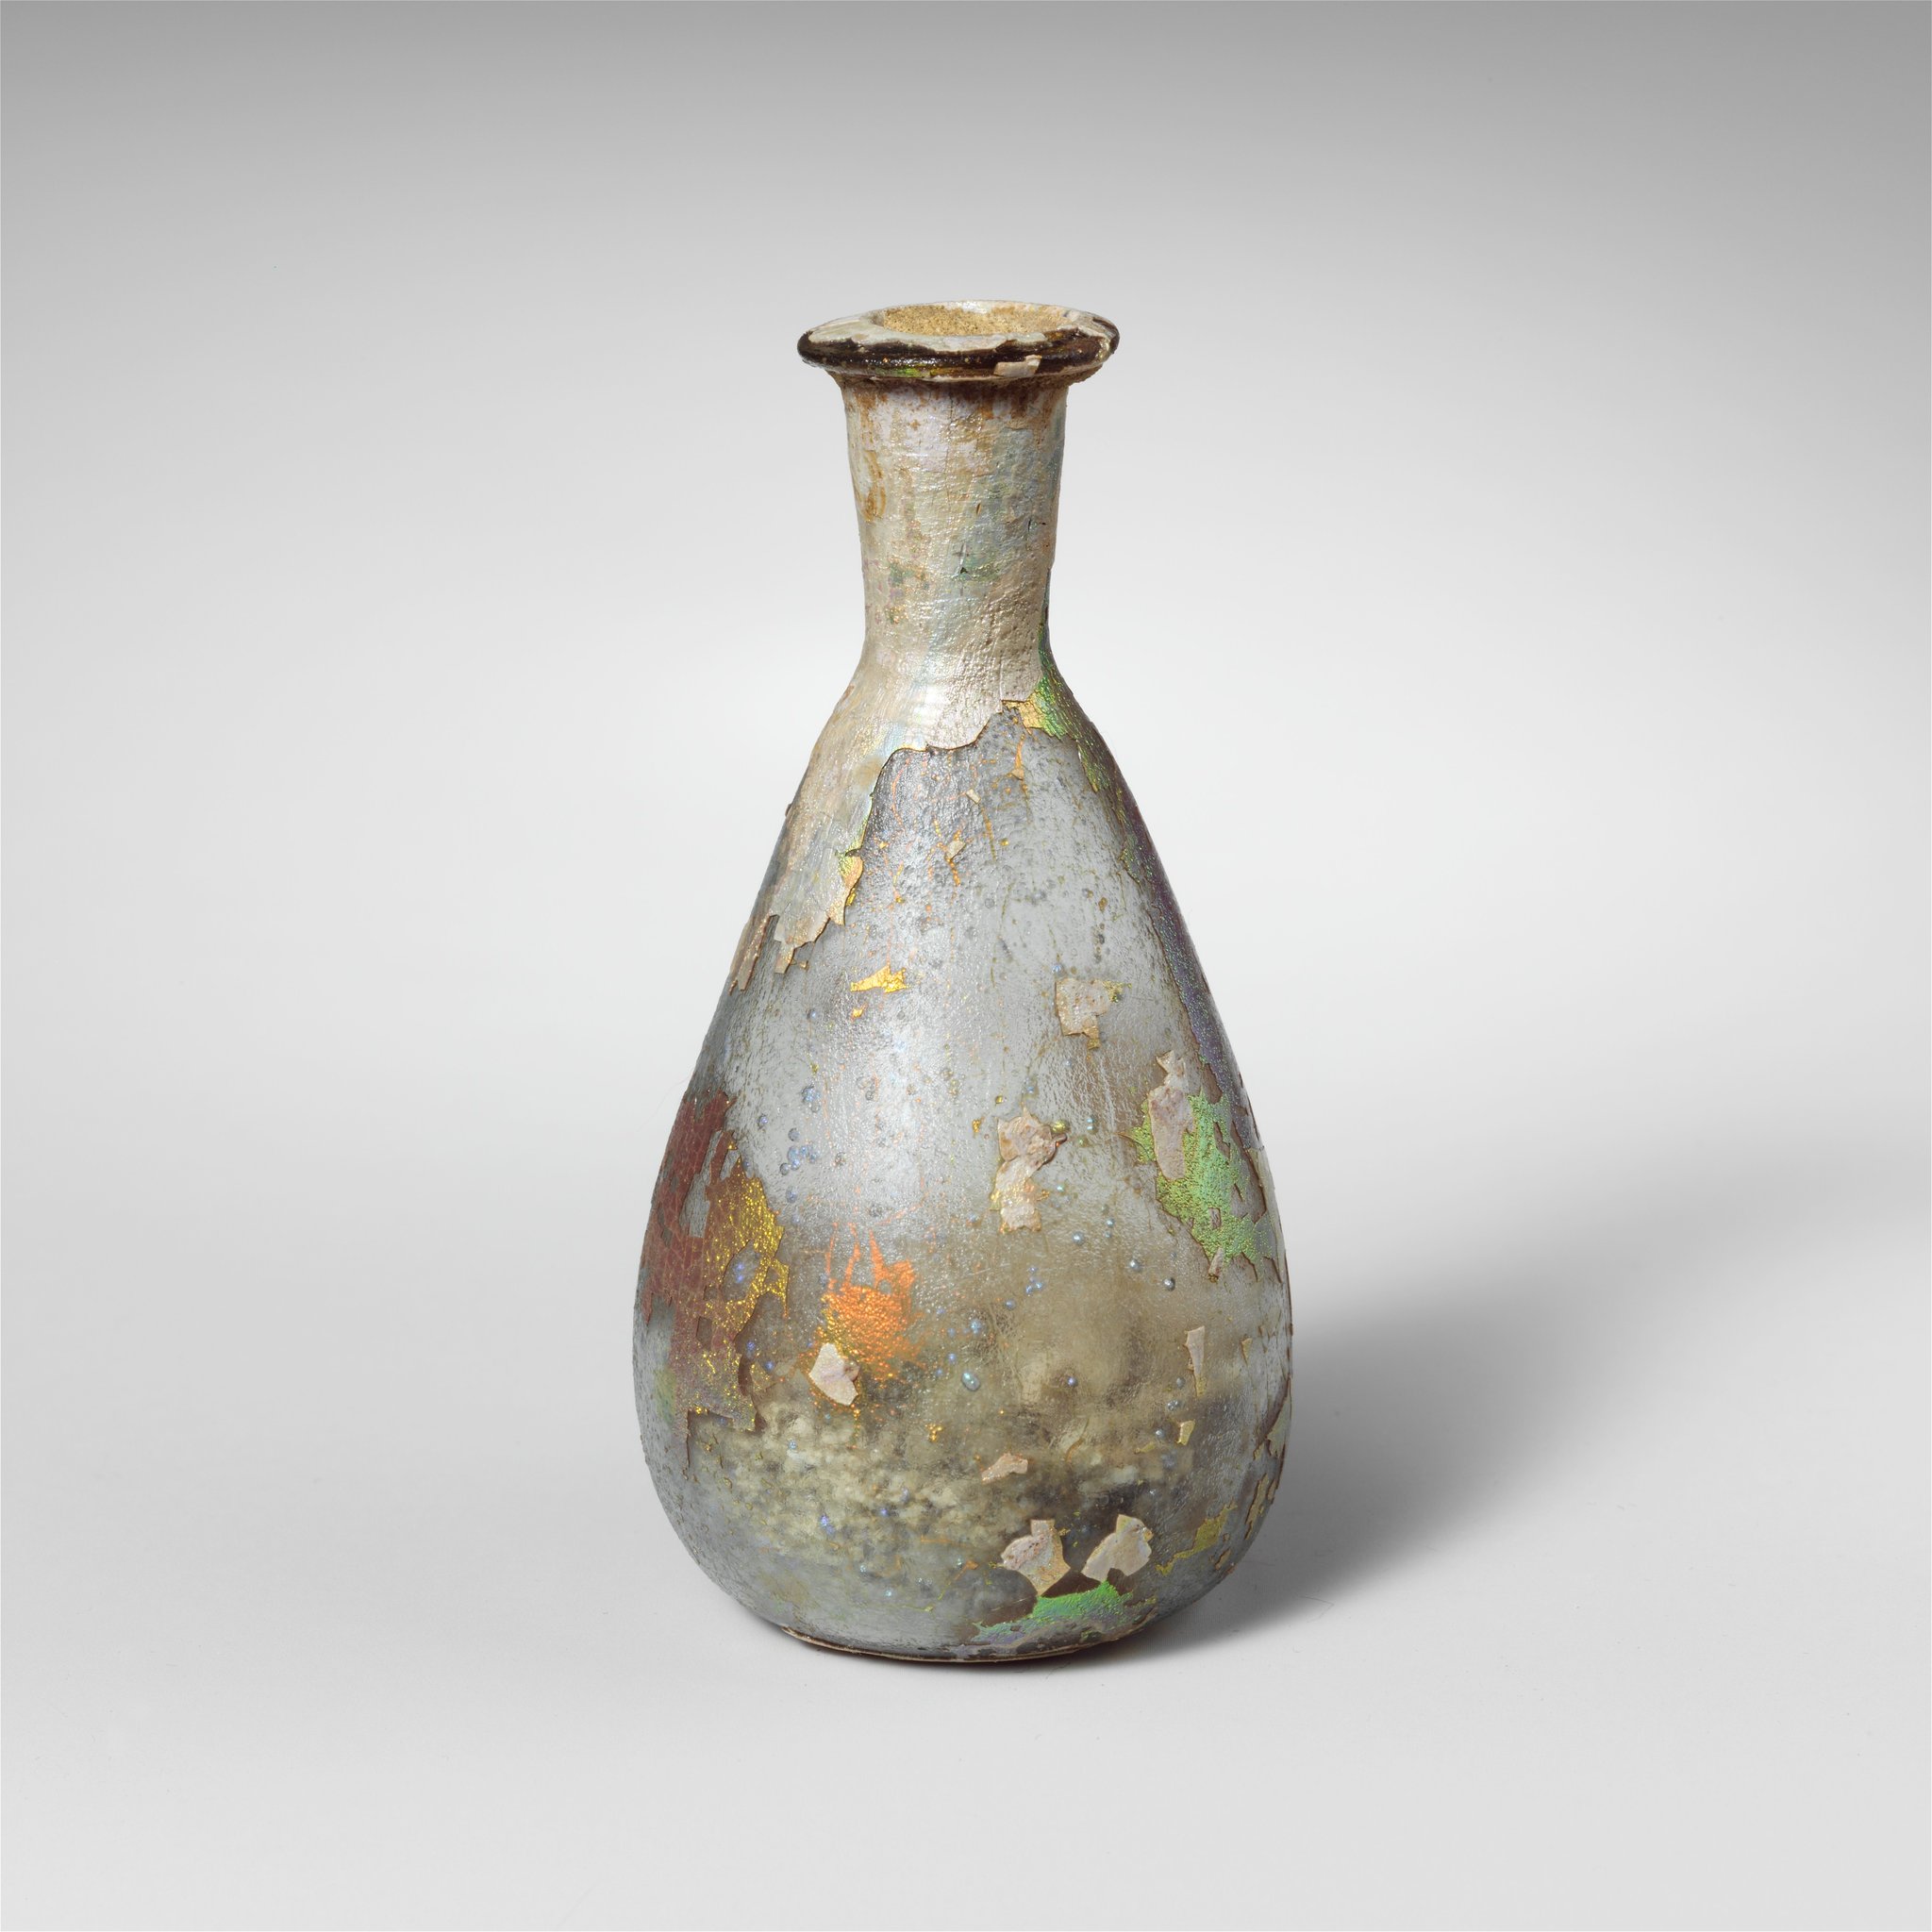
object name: perfume bottle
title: Glass perfume bottle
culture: roman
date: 1-200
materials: glass